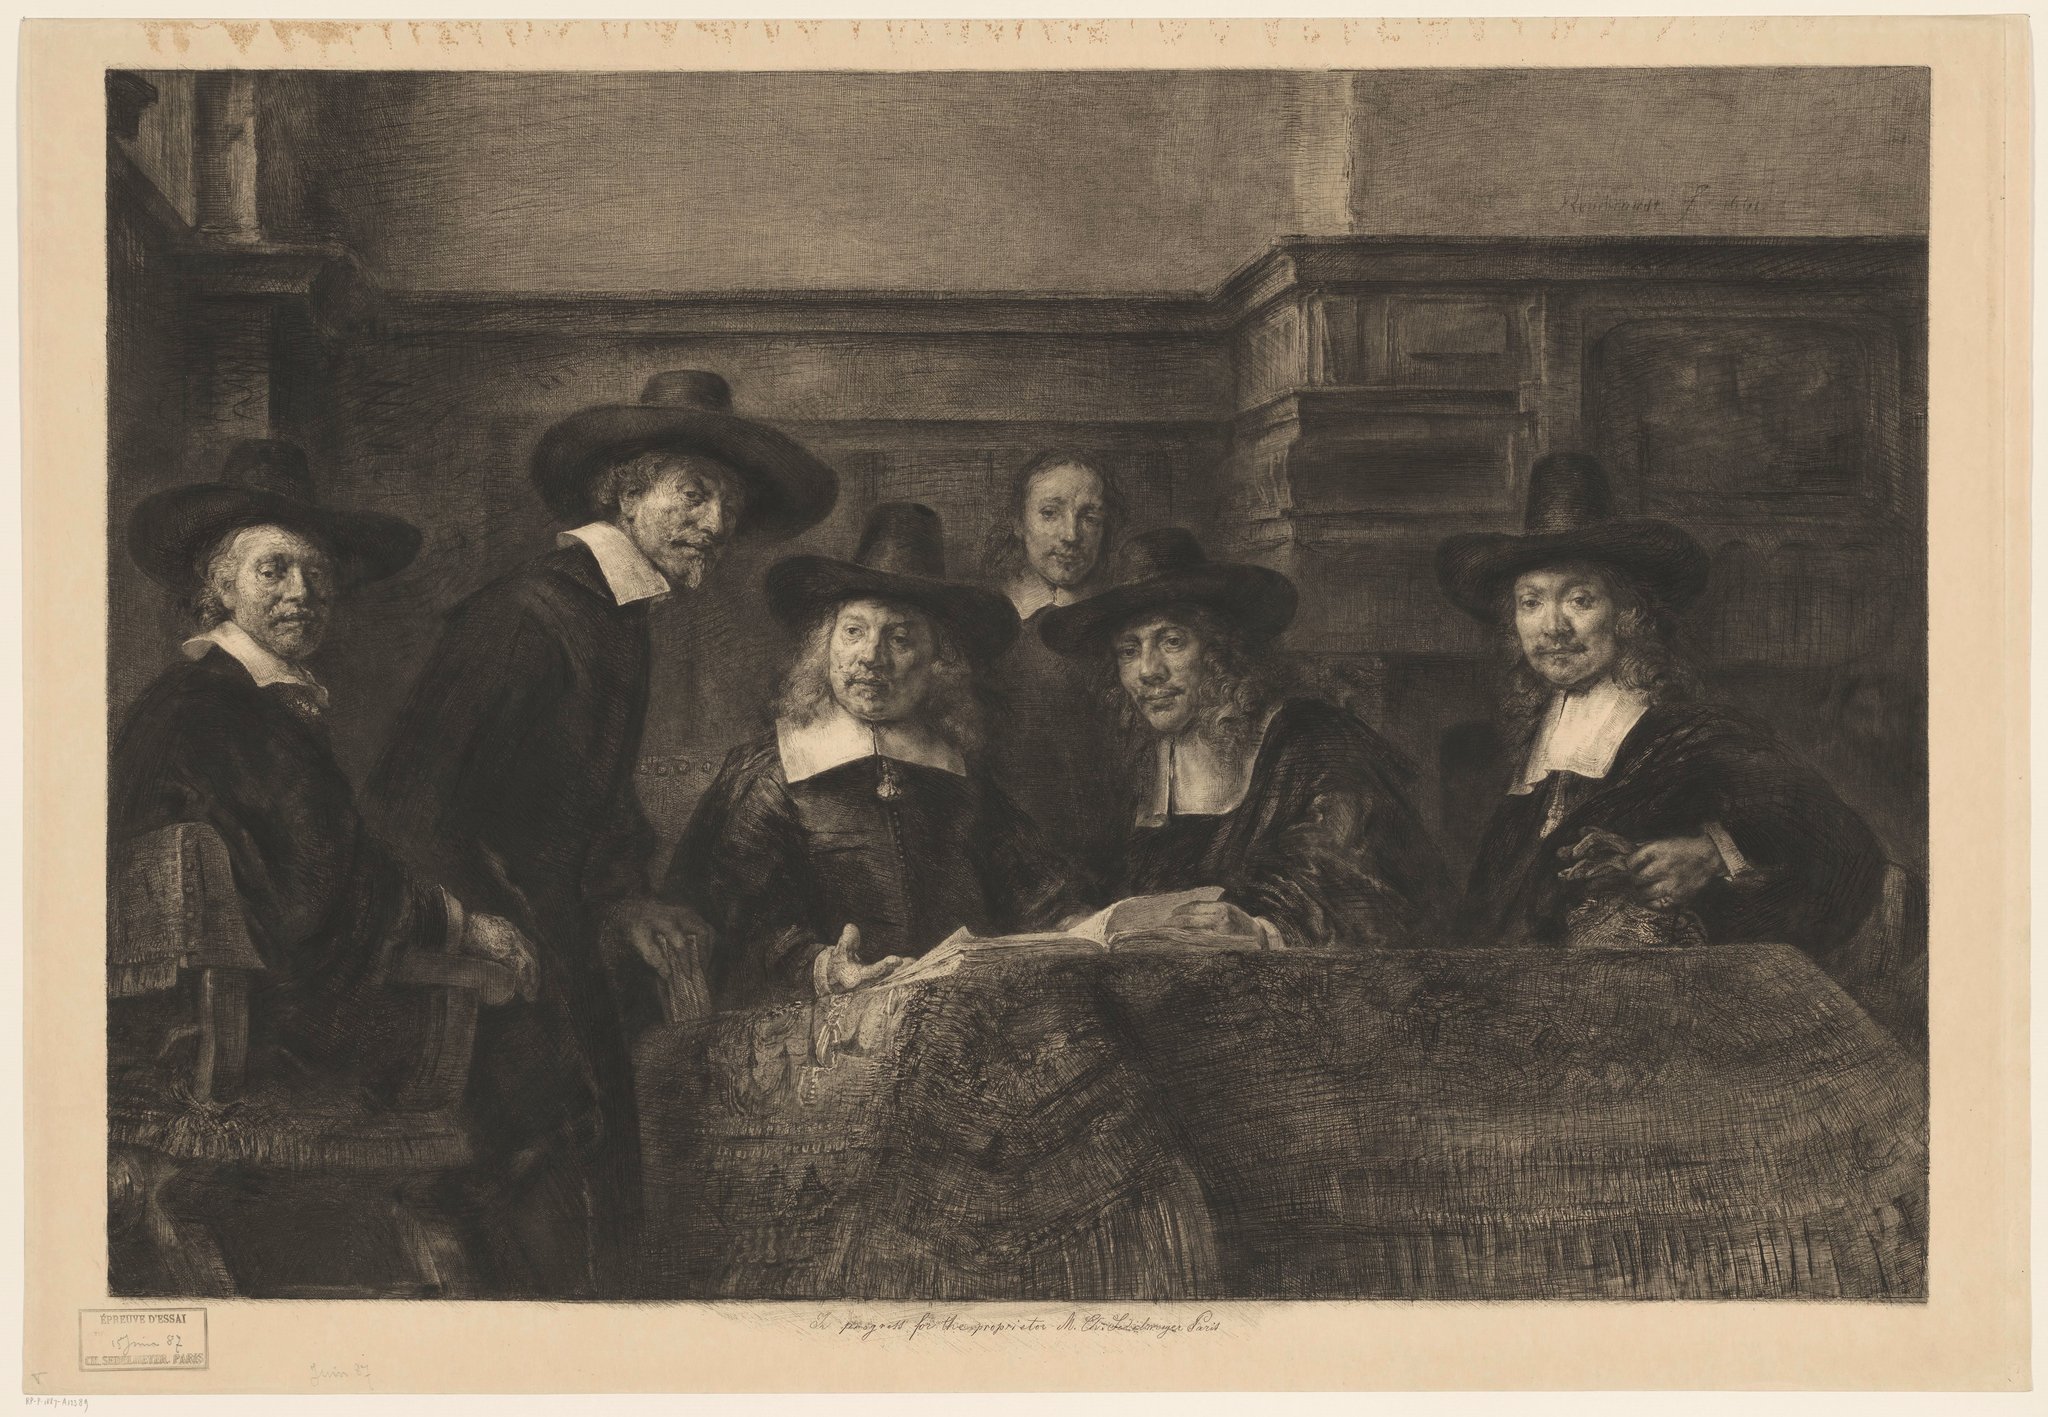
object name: print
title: De waardijns van het Amsterdamse lakenbereidersgilde, bekend als ‘De Staalmeesters’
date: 1887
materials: paper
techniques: etching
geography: paris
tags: amsterdam, hoorn (north holland), utrecht, book - mm - book open, table, officers trusted with control of quality, wool (material ~ textile industry)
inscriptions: stamp: ‘épreuve d'essai/ tir[ée le] 15 juin 87/ pour/ Ch. Sedelmeyer, Paris’, collector's mark: Lugt 2228